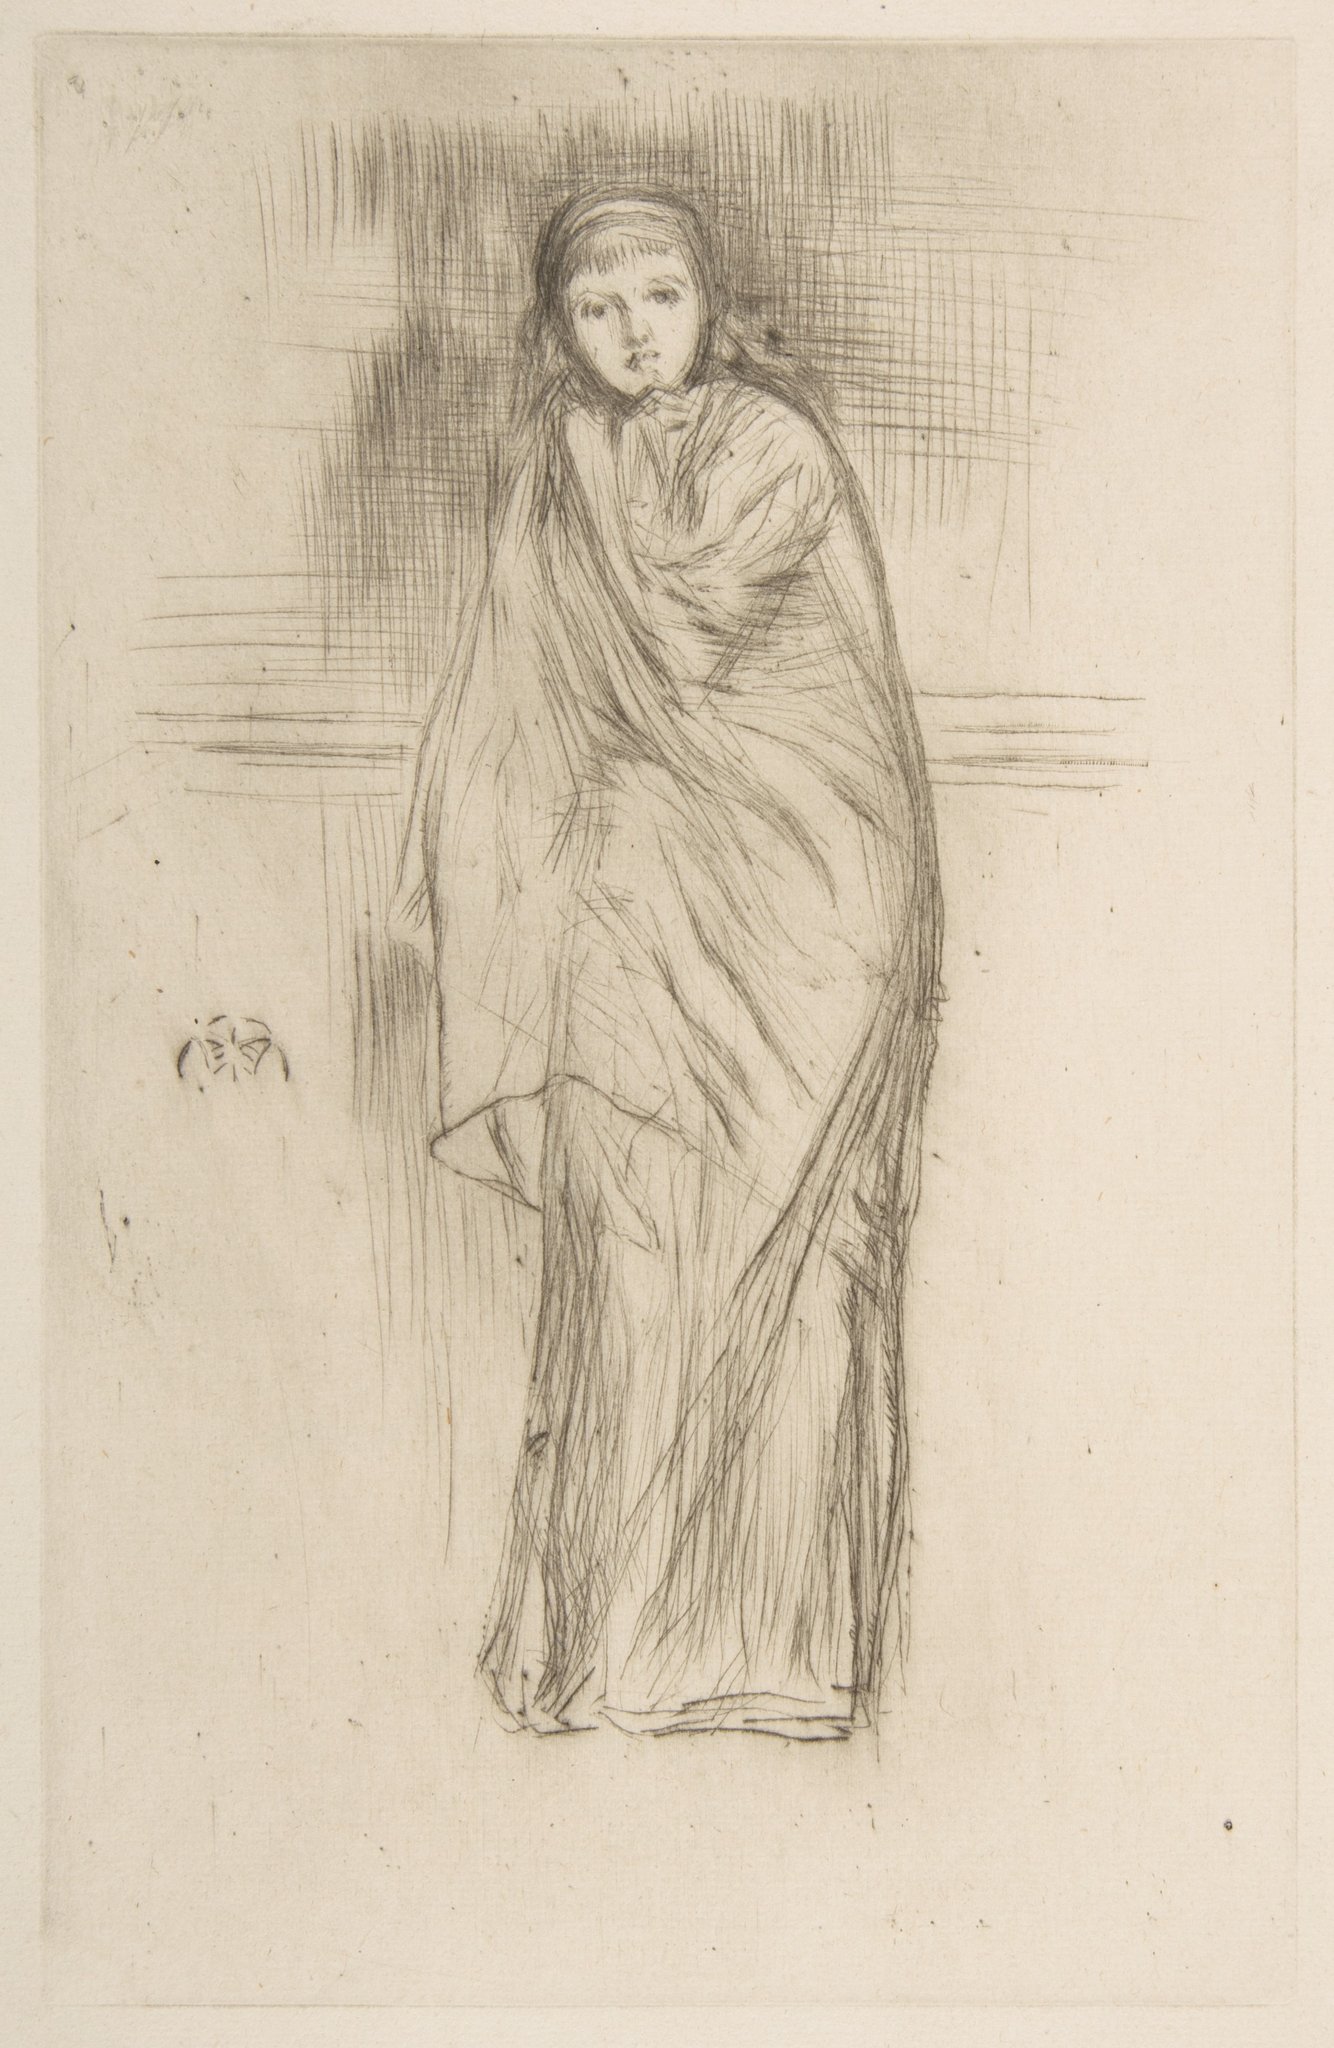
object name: print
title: The Model Resting (Draped Model)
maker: james mcneill whistler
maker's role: artist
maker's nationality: american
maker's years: 1834-1903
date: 1870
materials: ink, paper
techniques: drypoint, printing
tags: women